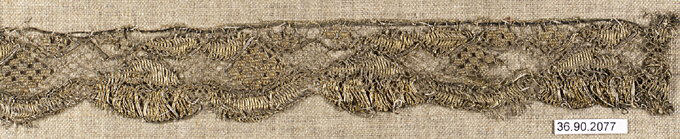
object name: piece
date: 1701-1800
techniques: lace